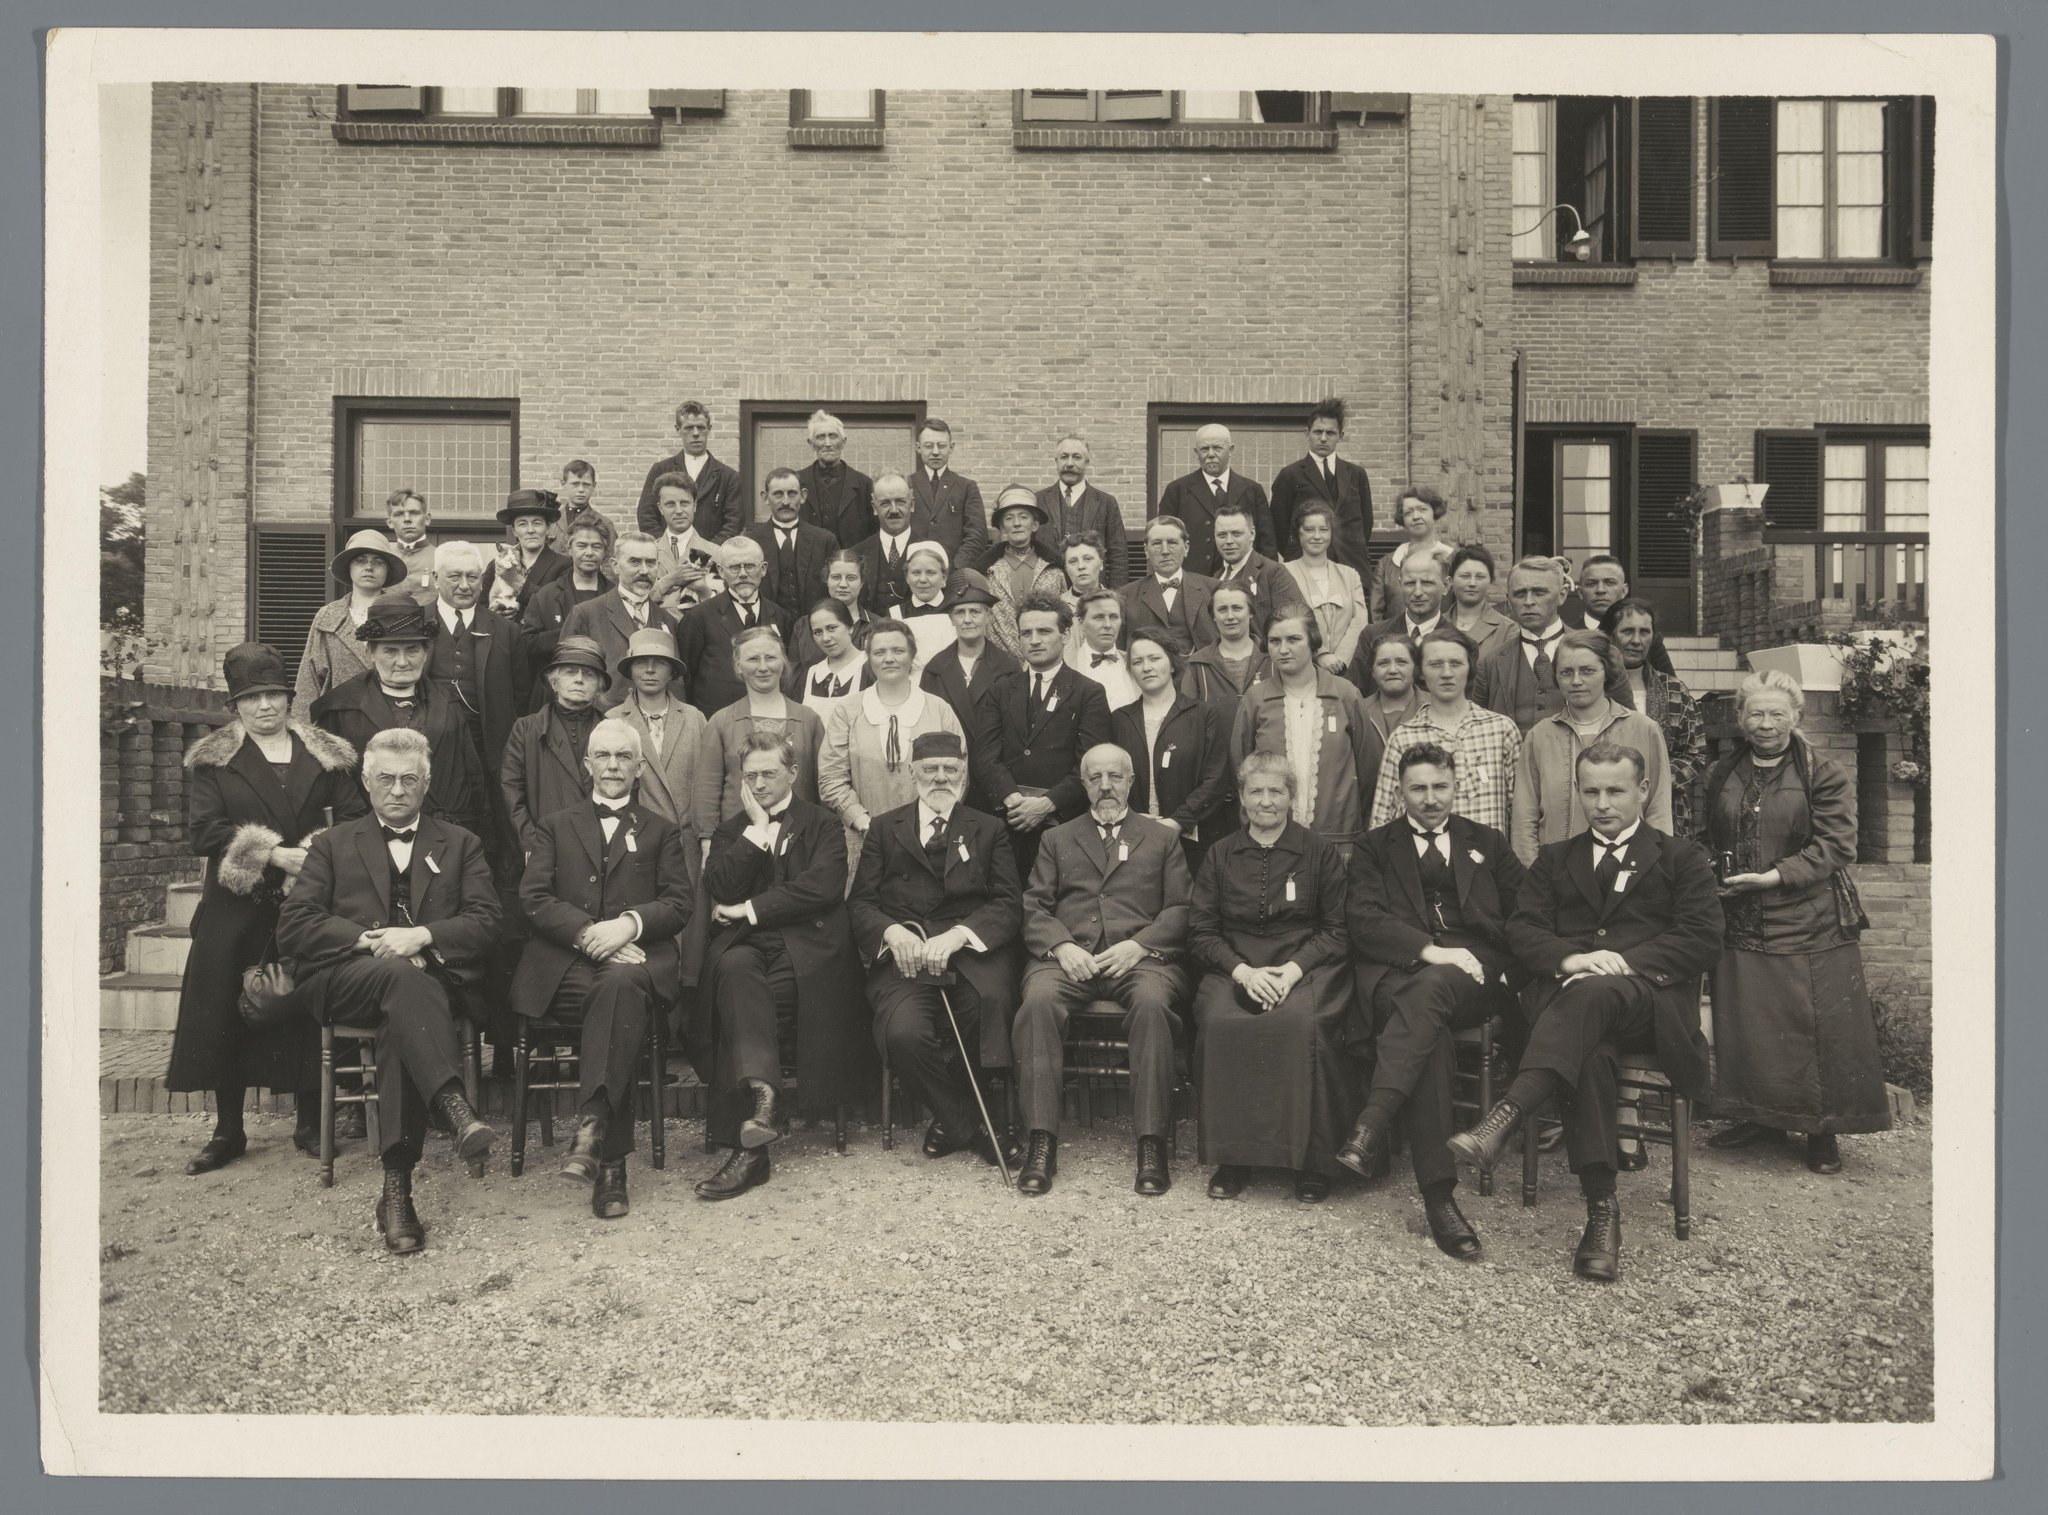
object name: photograph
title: Groepsportret bij een conferentie te Amerongen in 1927, mogelijk met Marie Breitner-Jordan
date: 1927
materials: paper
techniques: gelatin silver print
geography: amerongen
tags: marie jordan, anonymous historical persons portrayed in a group, in a group-portrait, amerongen